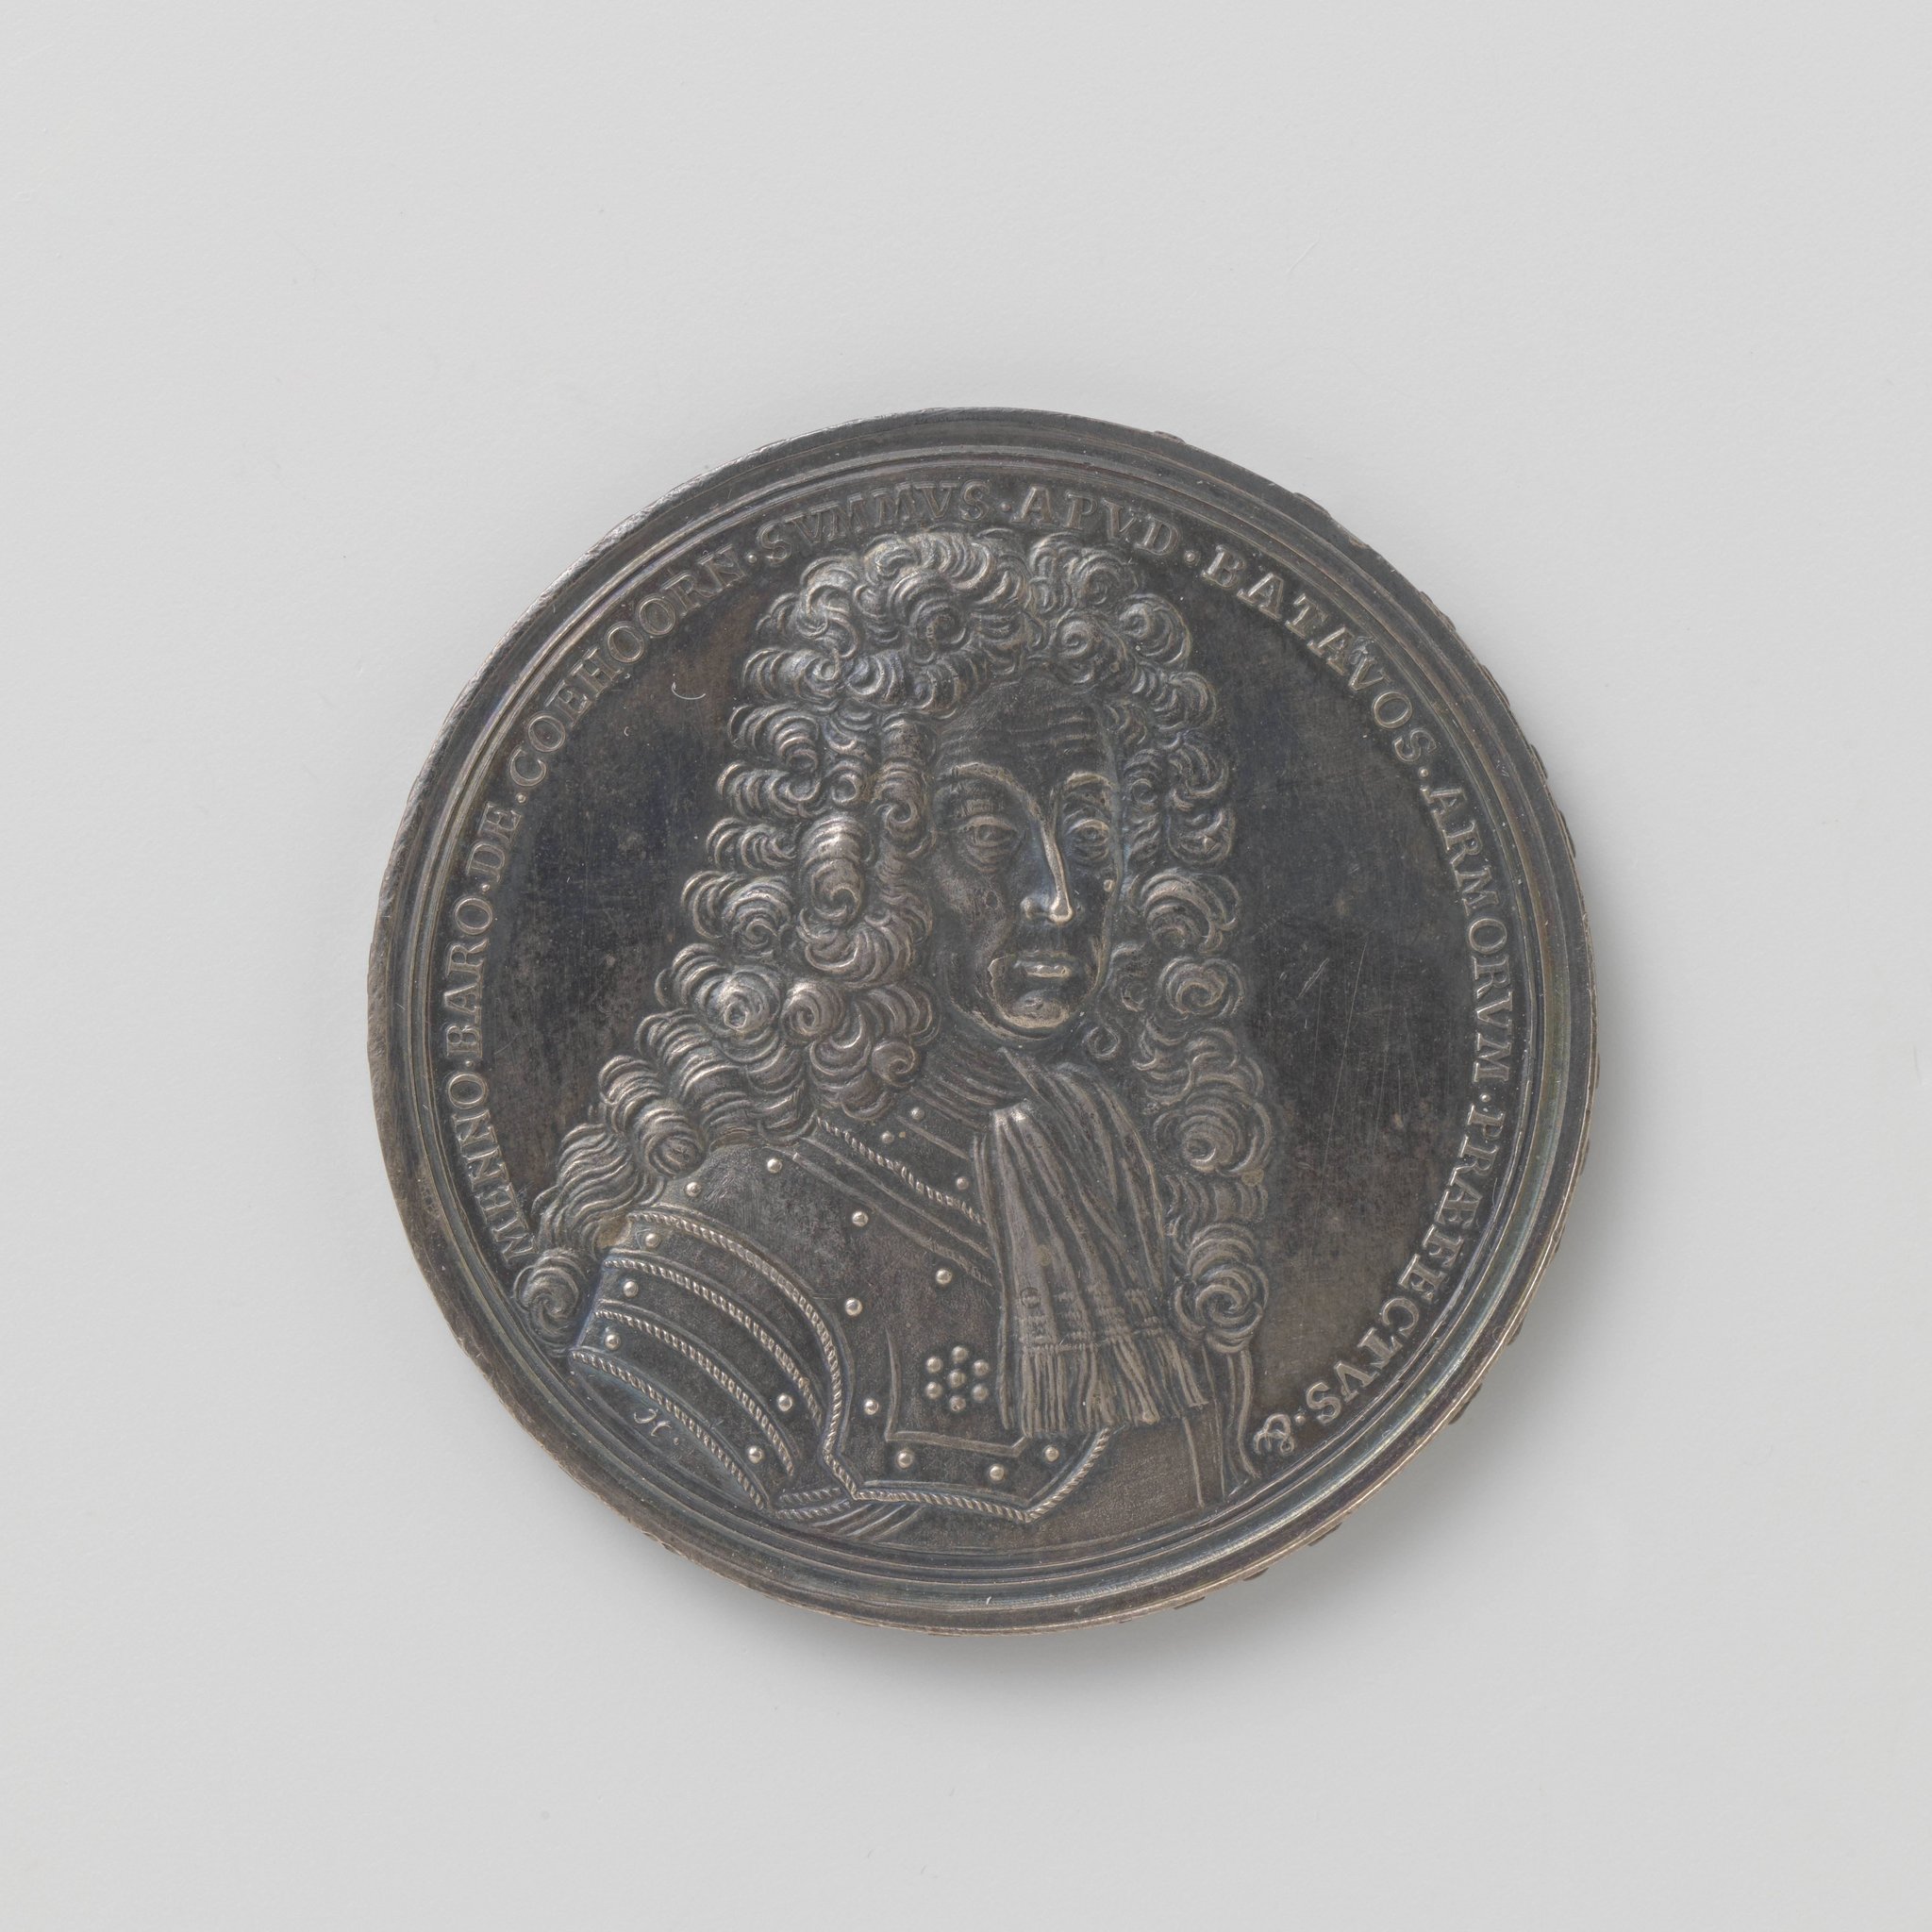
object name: history medal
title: Inname van Bonn door Menno van Coehoorn en bondgenoten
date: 1703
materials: silver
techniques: striking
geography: nuremberg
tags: the hague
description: Zilveren penning. Voorzijde: borststuk man (Menno van Coehoorn) binnen omschrift. Keerzijde: gezicht op stad (Bonn) binnen omschrift, boven opschrift; randschrift